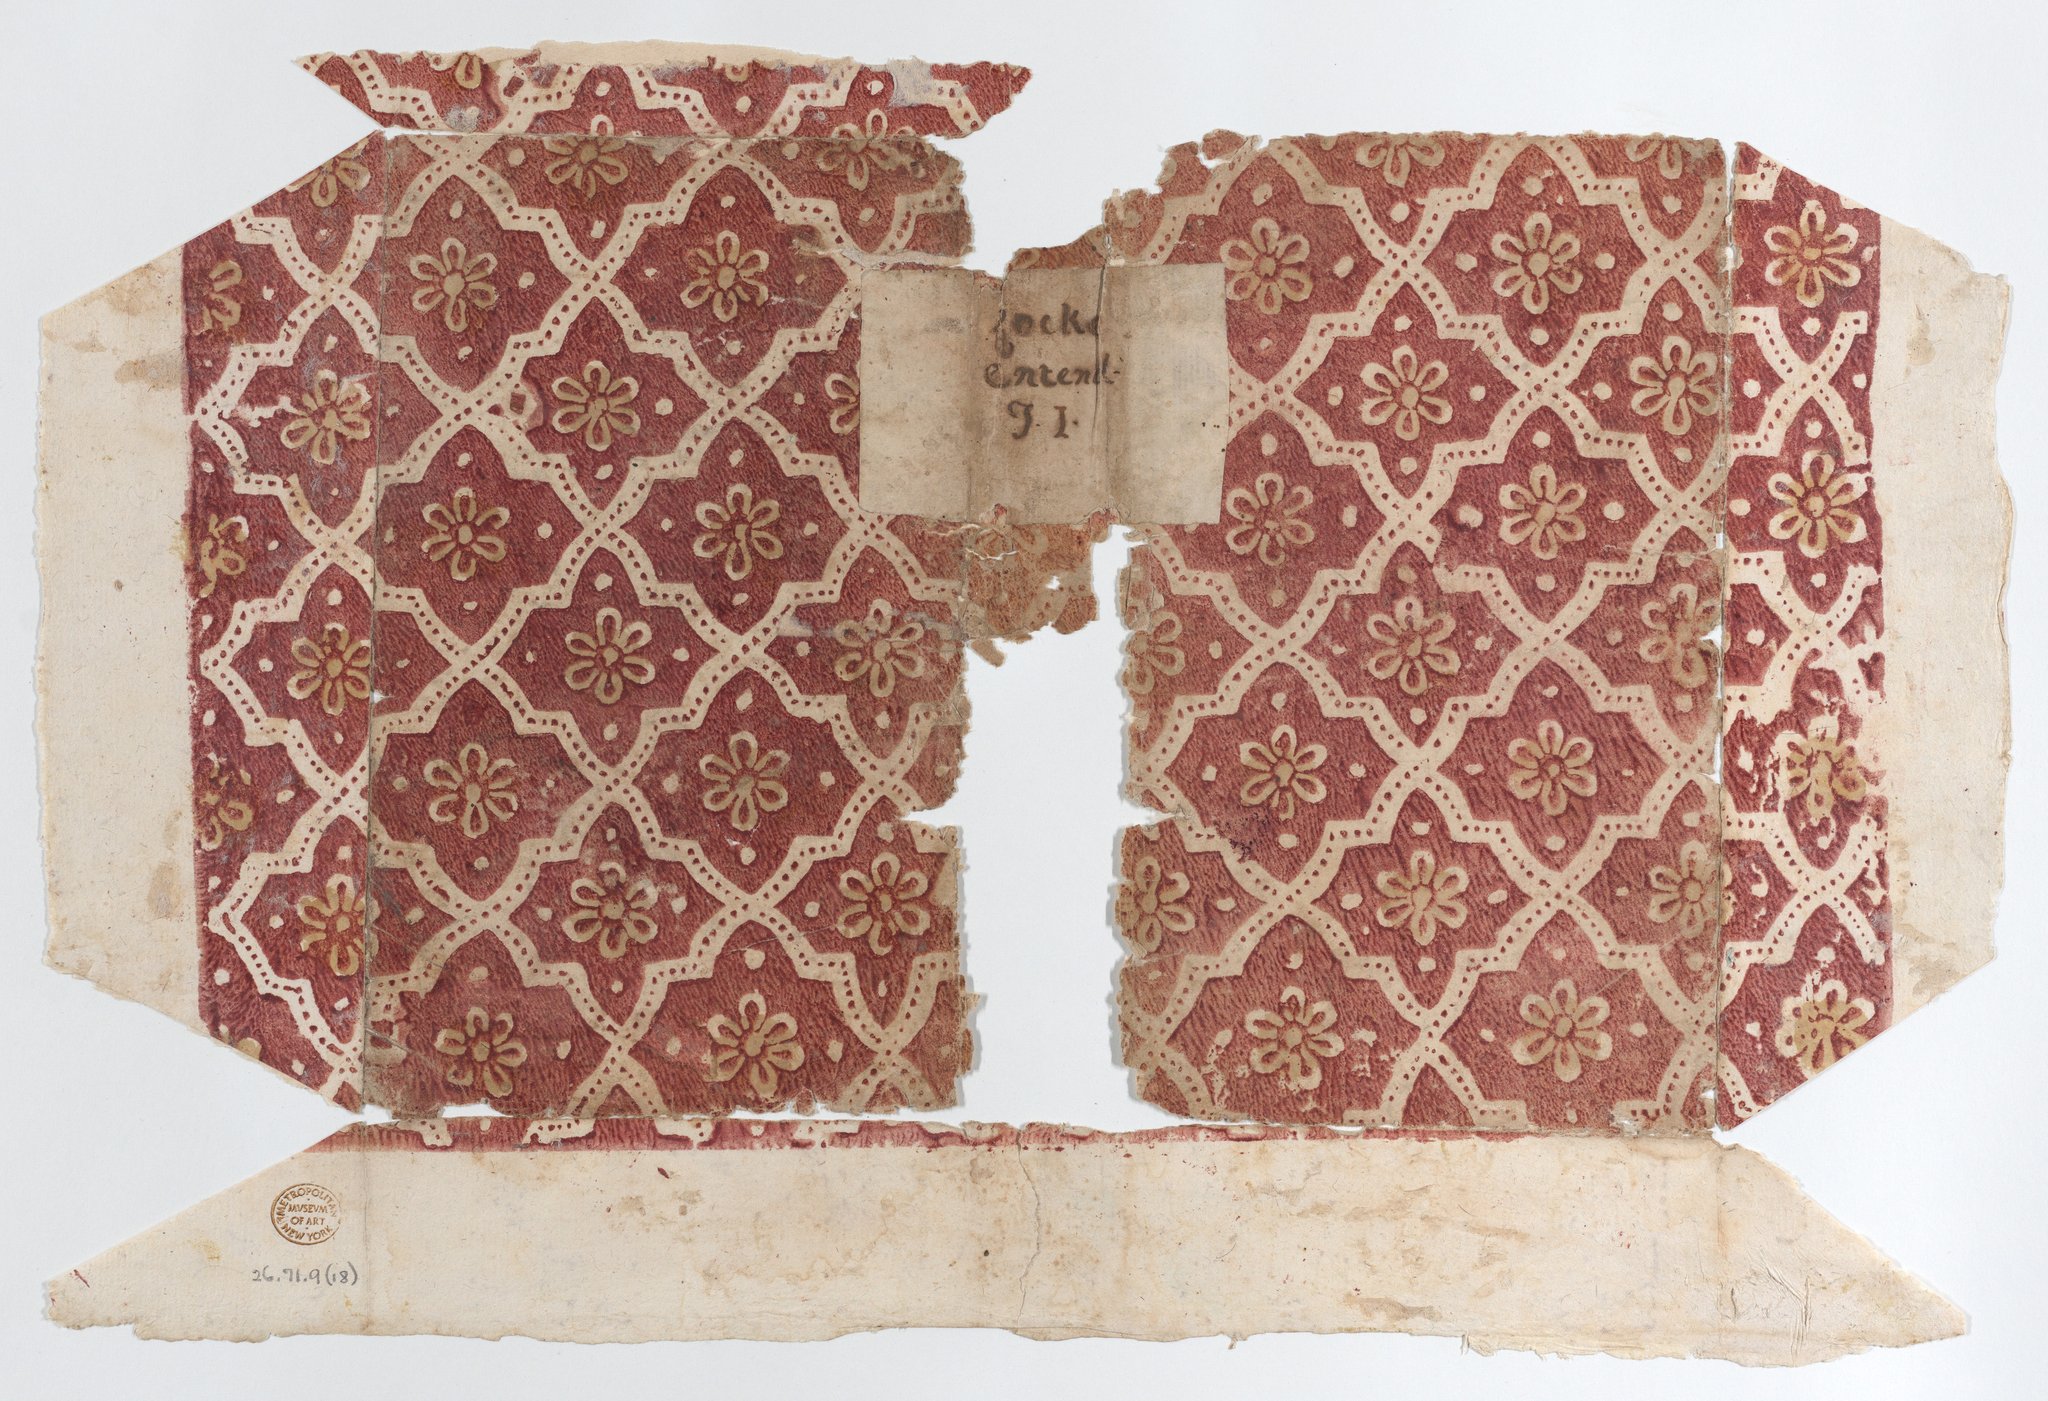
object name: print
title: Book cover with red geometric and flower pattern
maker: Anonymous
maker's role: artist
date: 1801-1900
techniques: relief print